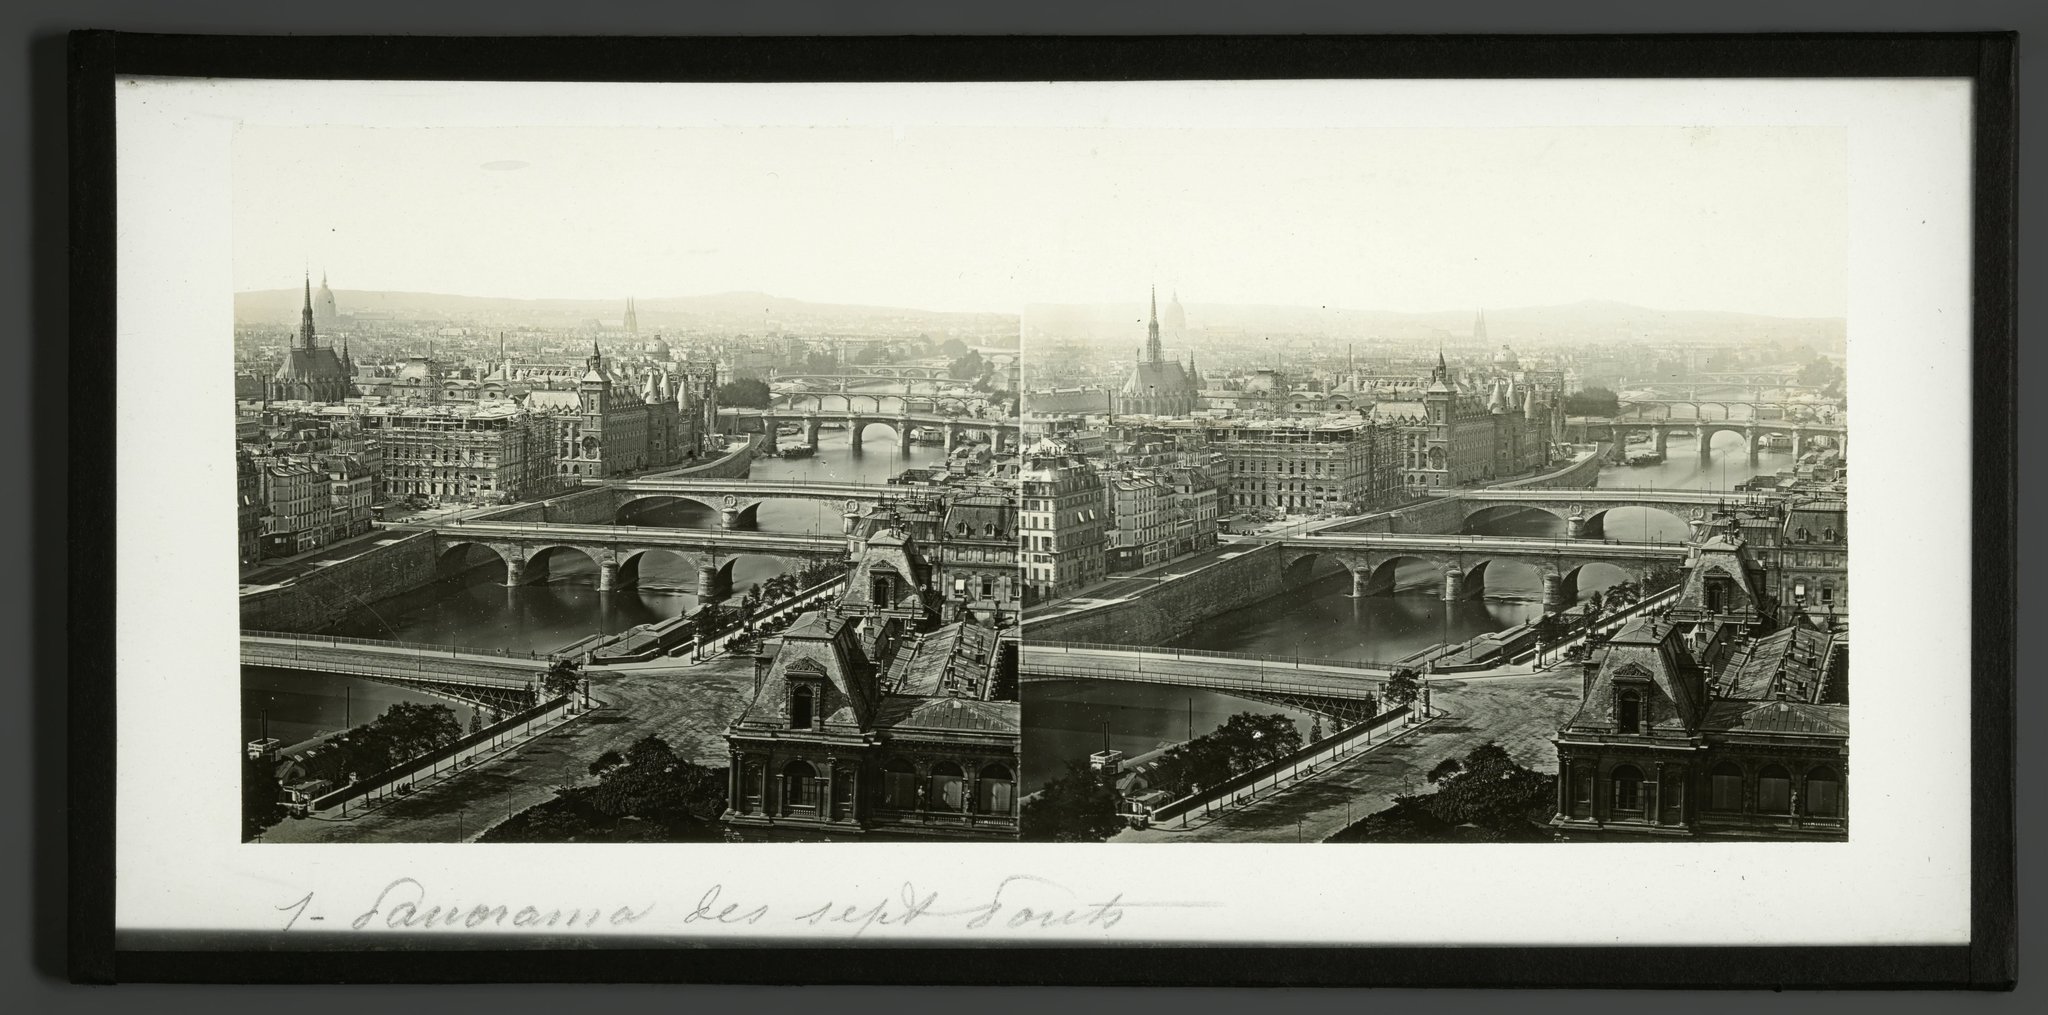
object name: stereoscopic photograph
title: Gezicht op Parijs met zeven bruggen over de Seine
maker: Anonymous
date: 1856-1890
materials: glass, paper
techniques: slide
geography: paris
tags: bridge in city across river, canal, etc. (+ city(-scape) with figures, staffage), city-view in general; 'veduta', paris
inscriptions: annotation: ‘1 - Panorama des sept ponts’